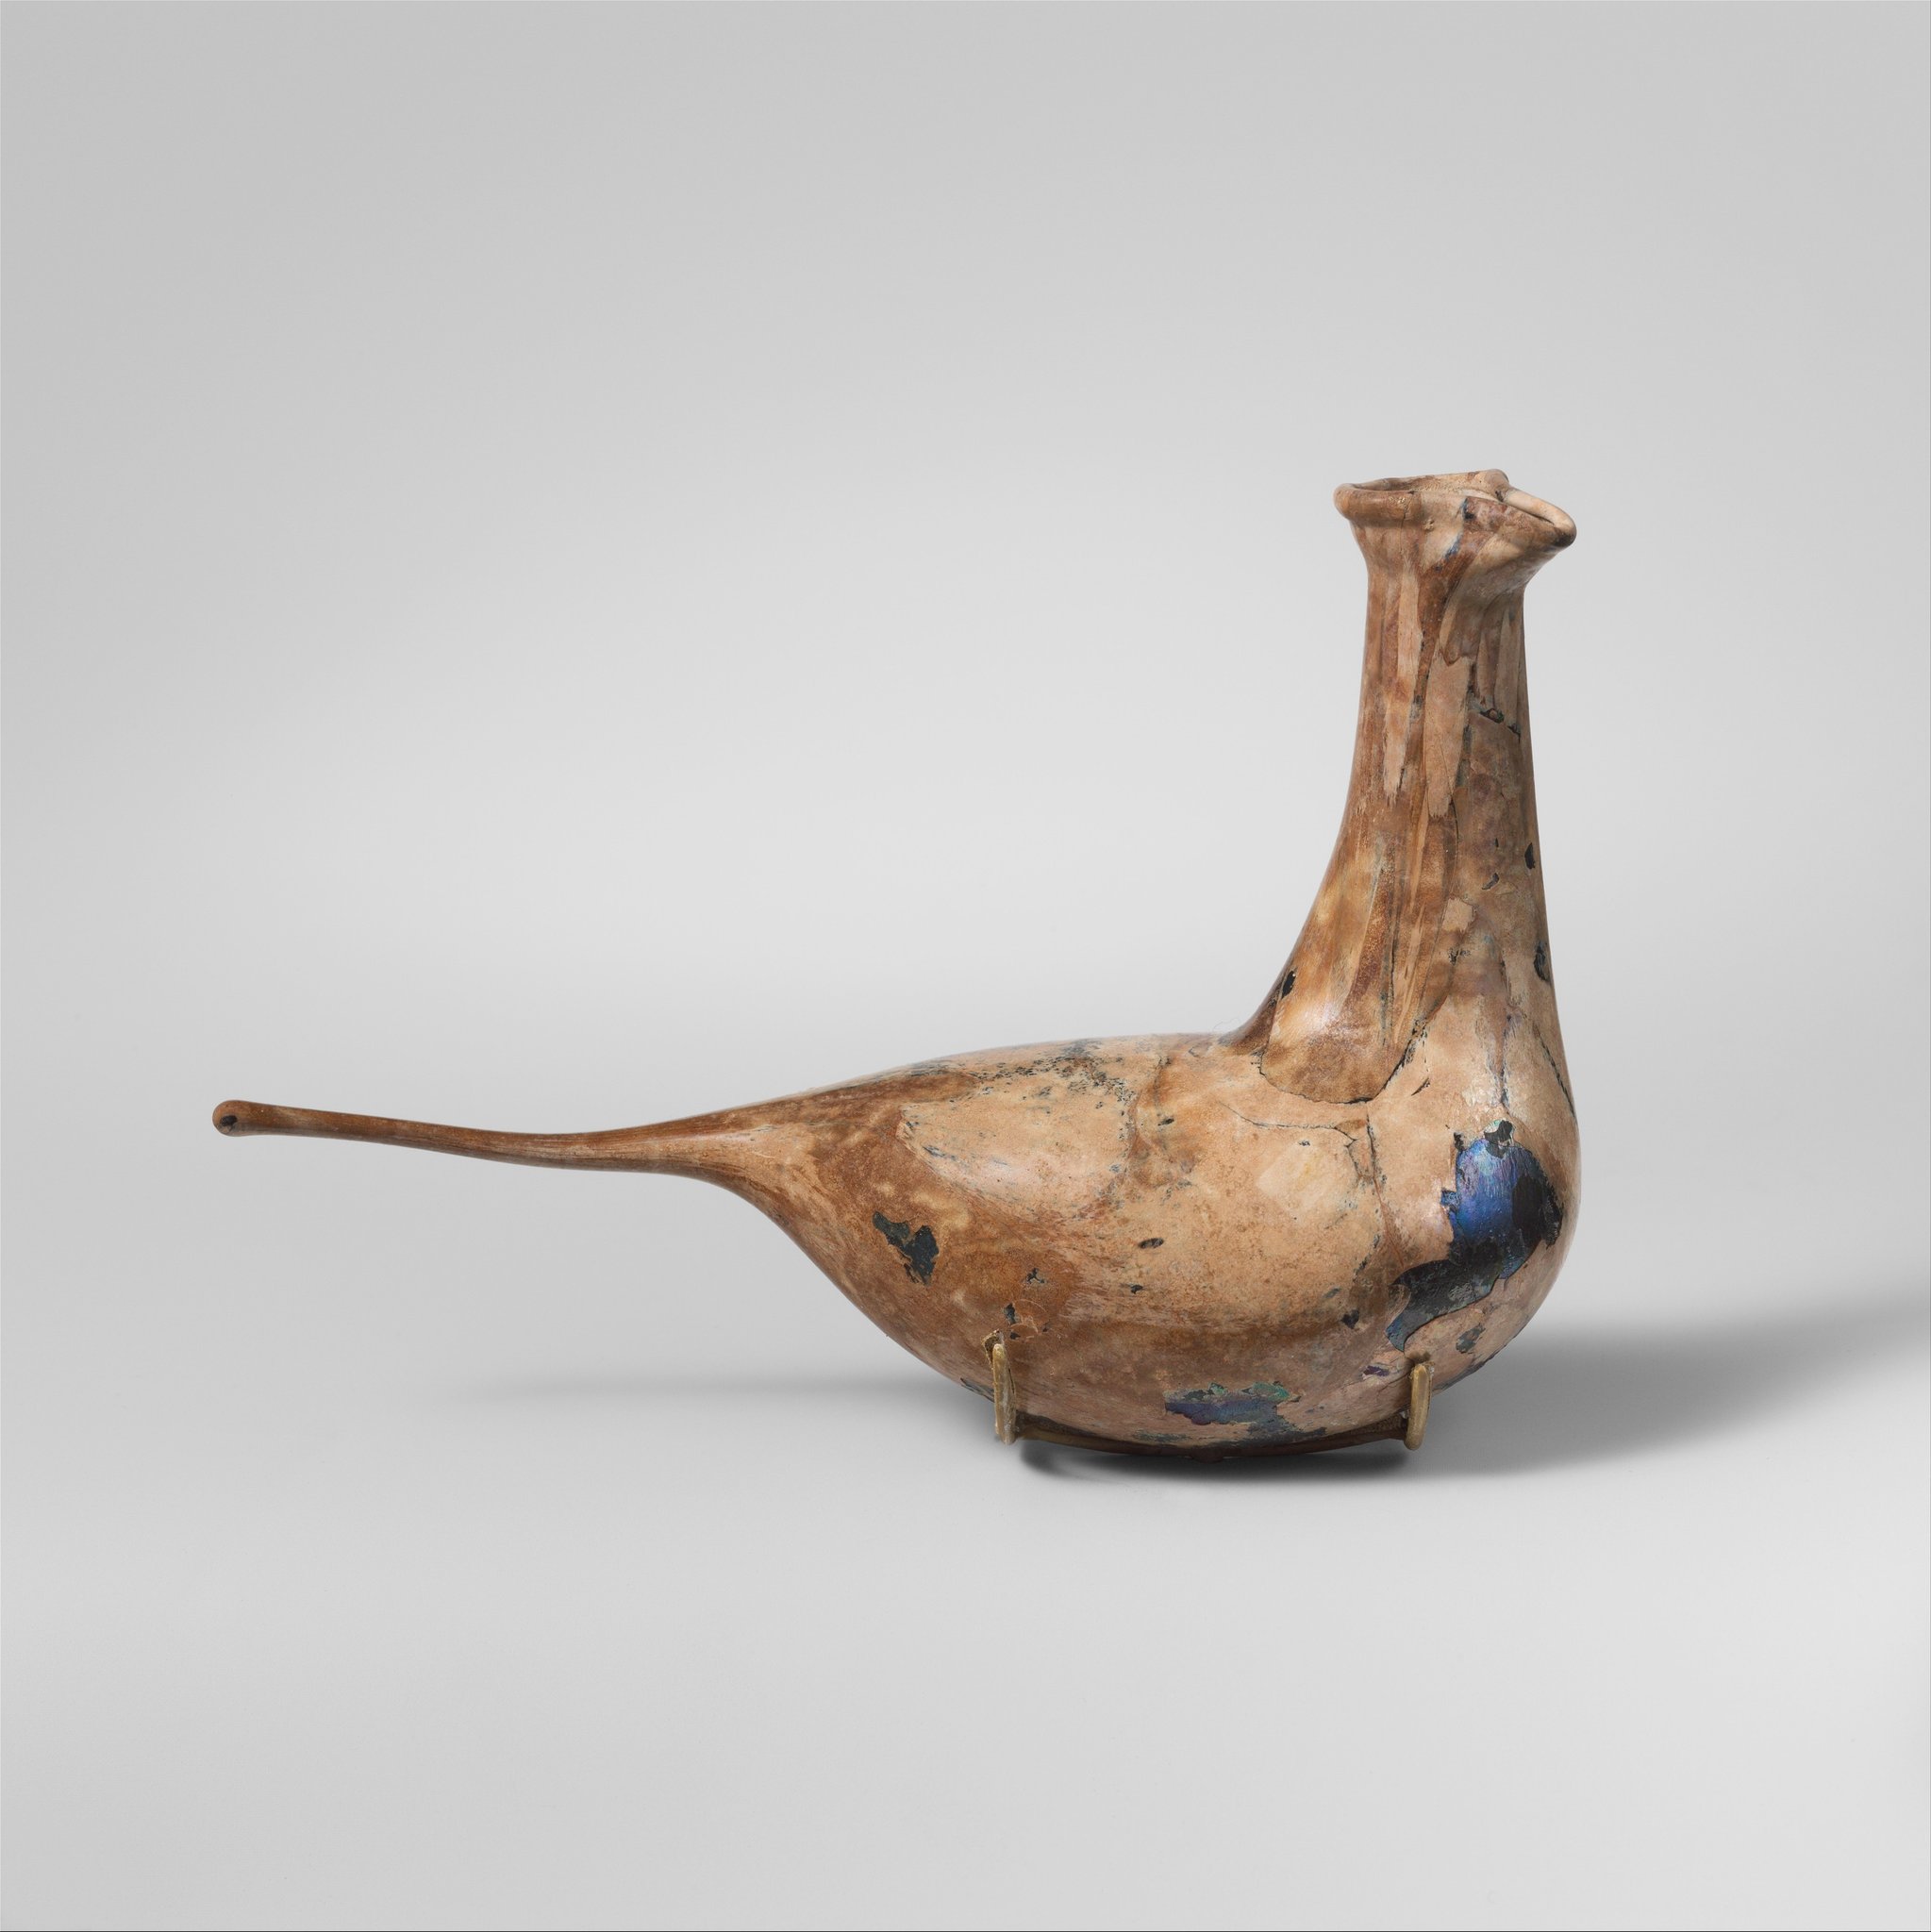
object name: bottle in the form of a bird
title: Glass bottle in the shape of a bird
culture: roman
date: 1-100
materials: glass, onyx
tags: birds